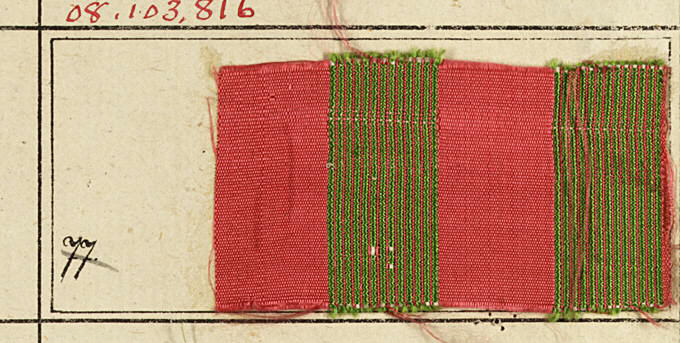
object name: ribbon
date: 1701-1900